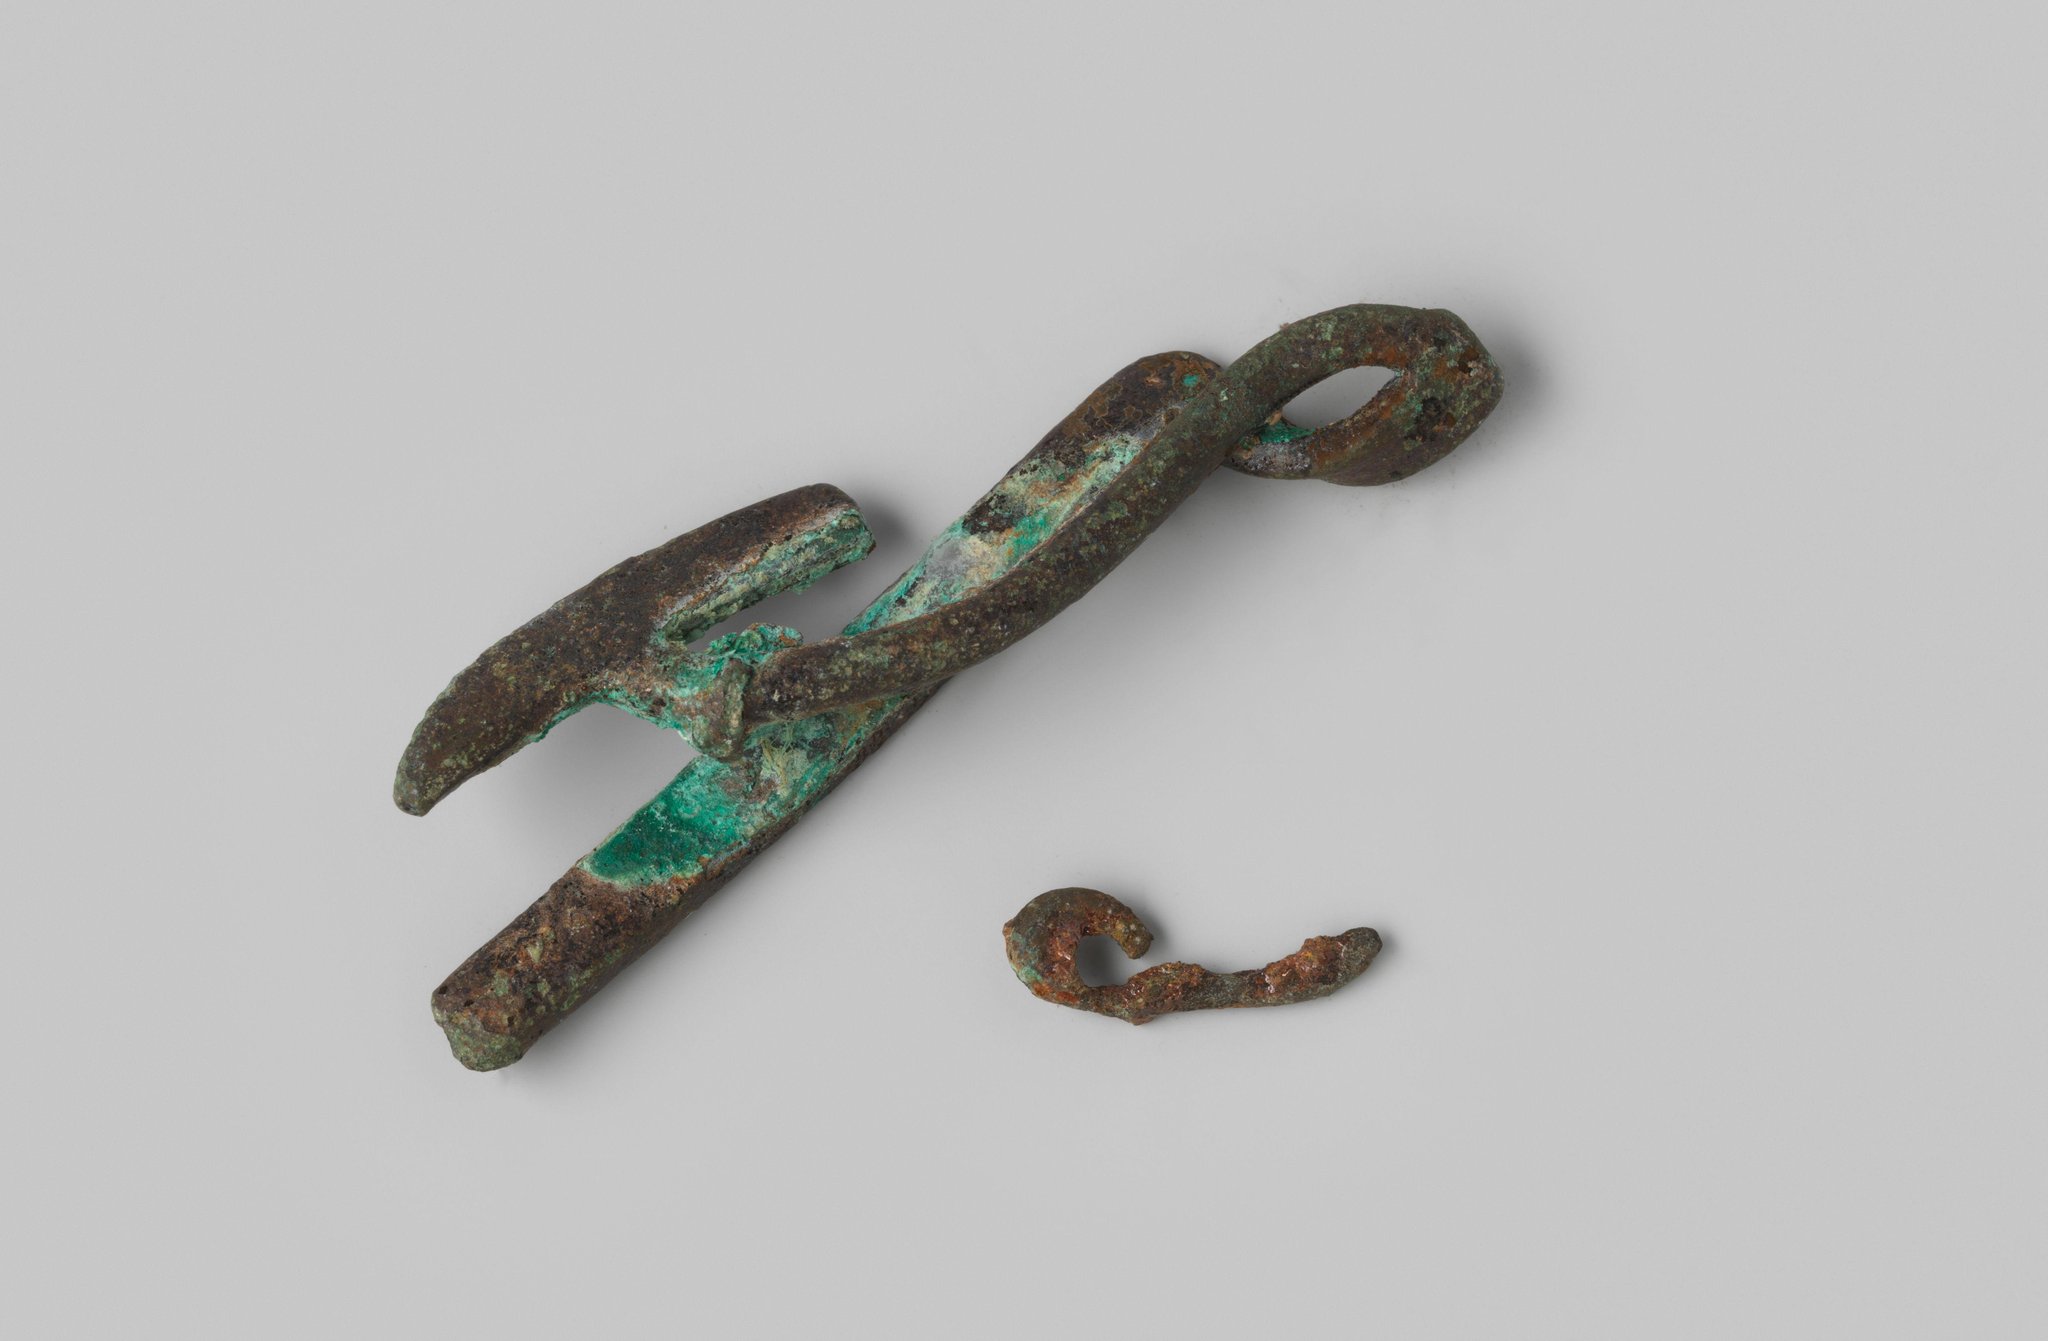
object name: belt buckle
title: Fragmenten riemgespen uit het wrak van de Oost-Indiëvaarder Hollandia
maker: Anonymous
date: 1700-1743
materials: copper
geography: netherlands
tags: verenigde oostindische compagnie, hollandia (schip), annet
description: Rectangular, fragm id. NG 1980-27H2796, belt buckle.